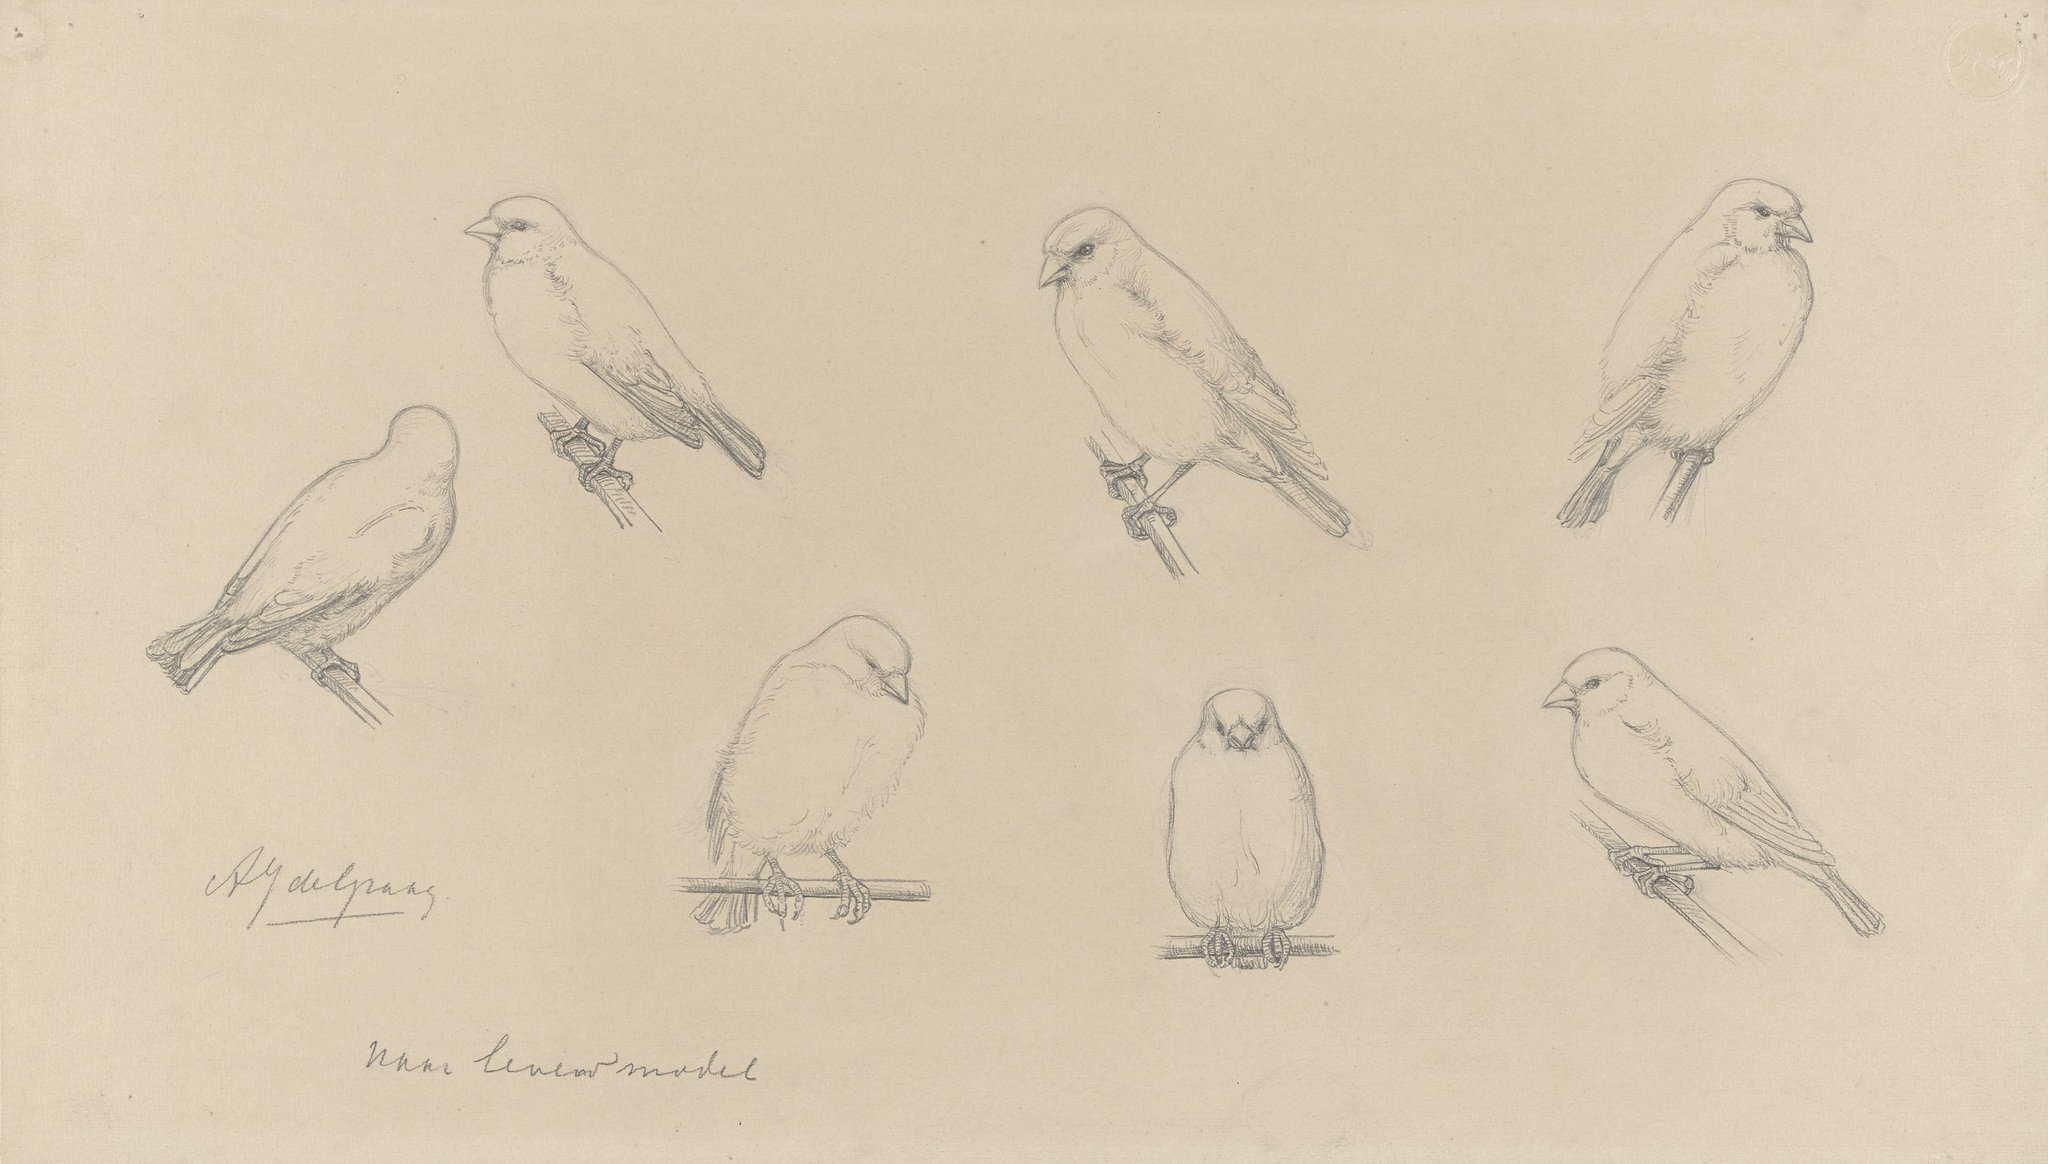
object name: drawing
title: Studieblad met kanaries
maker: julie de graag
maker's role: draughtsman, print maker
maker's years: 1877-1924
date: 1887-1924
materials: paper, pencil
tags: song-birds: canary